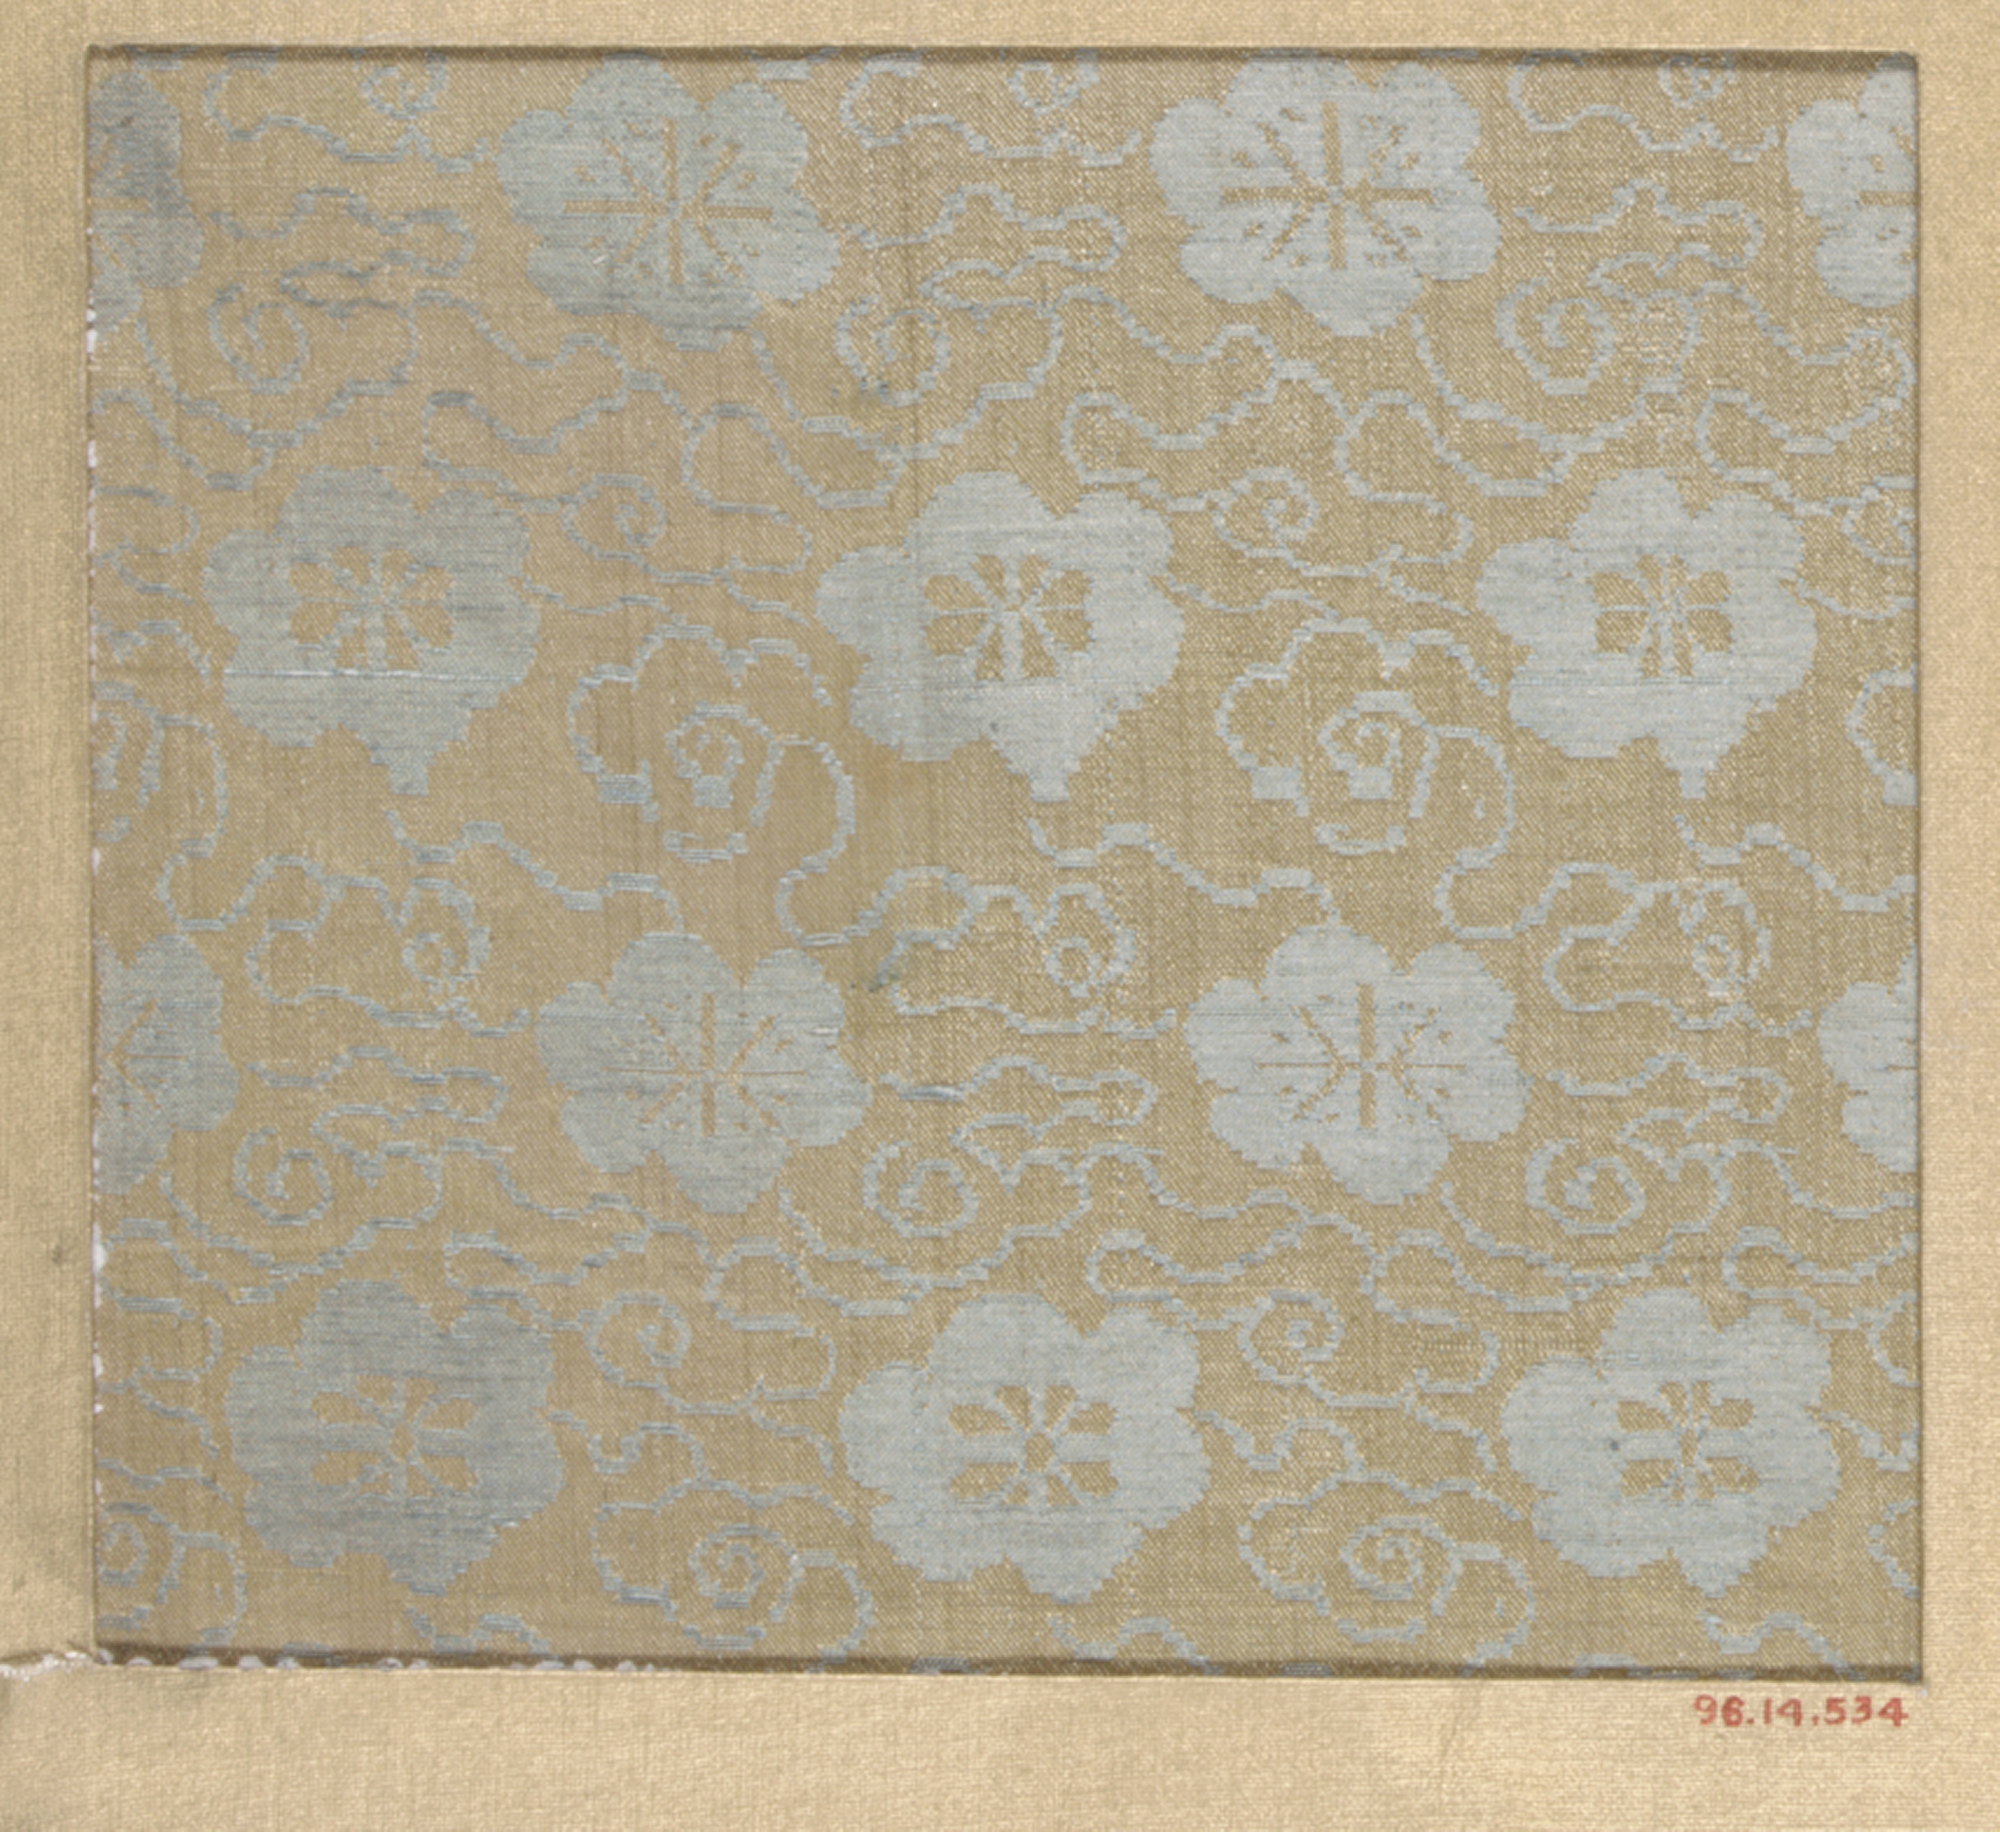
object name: piece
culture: japanese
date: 1701-1900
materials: silk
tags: flowers